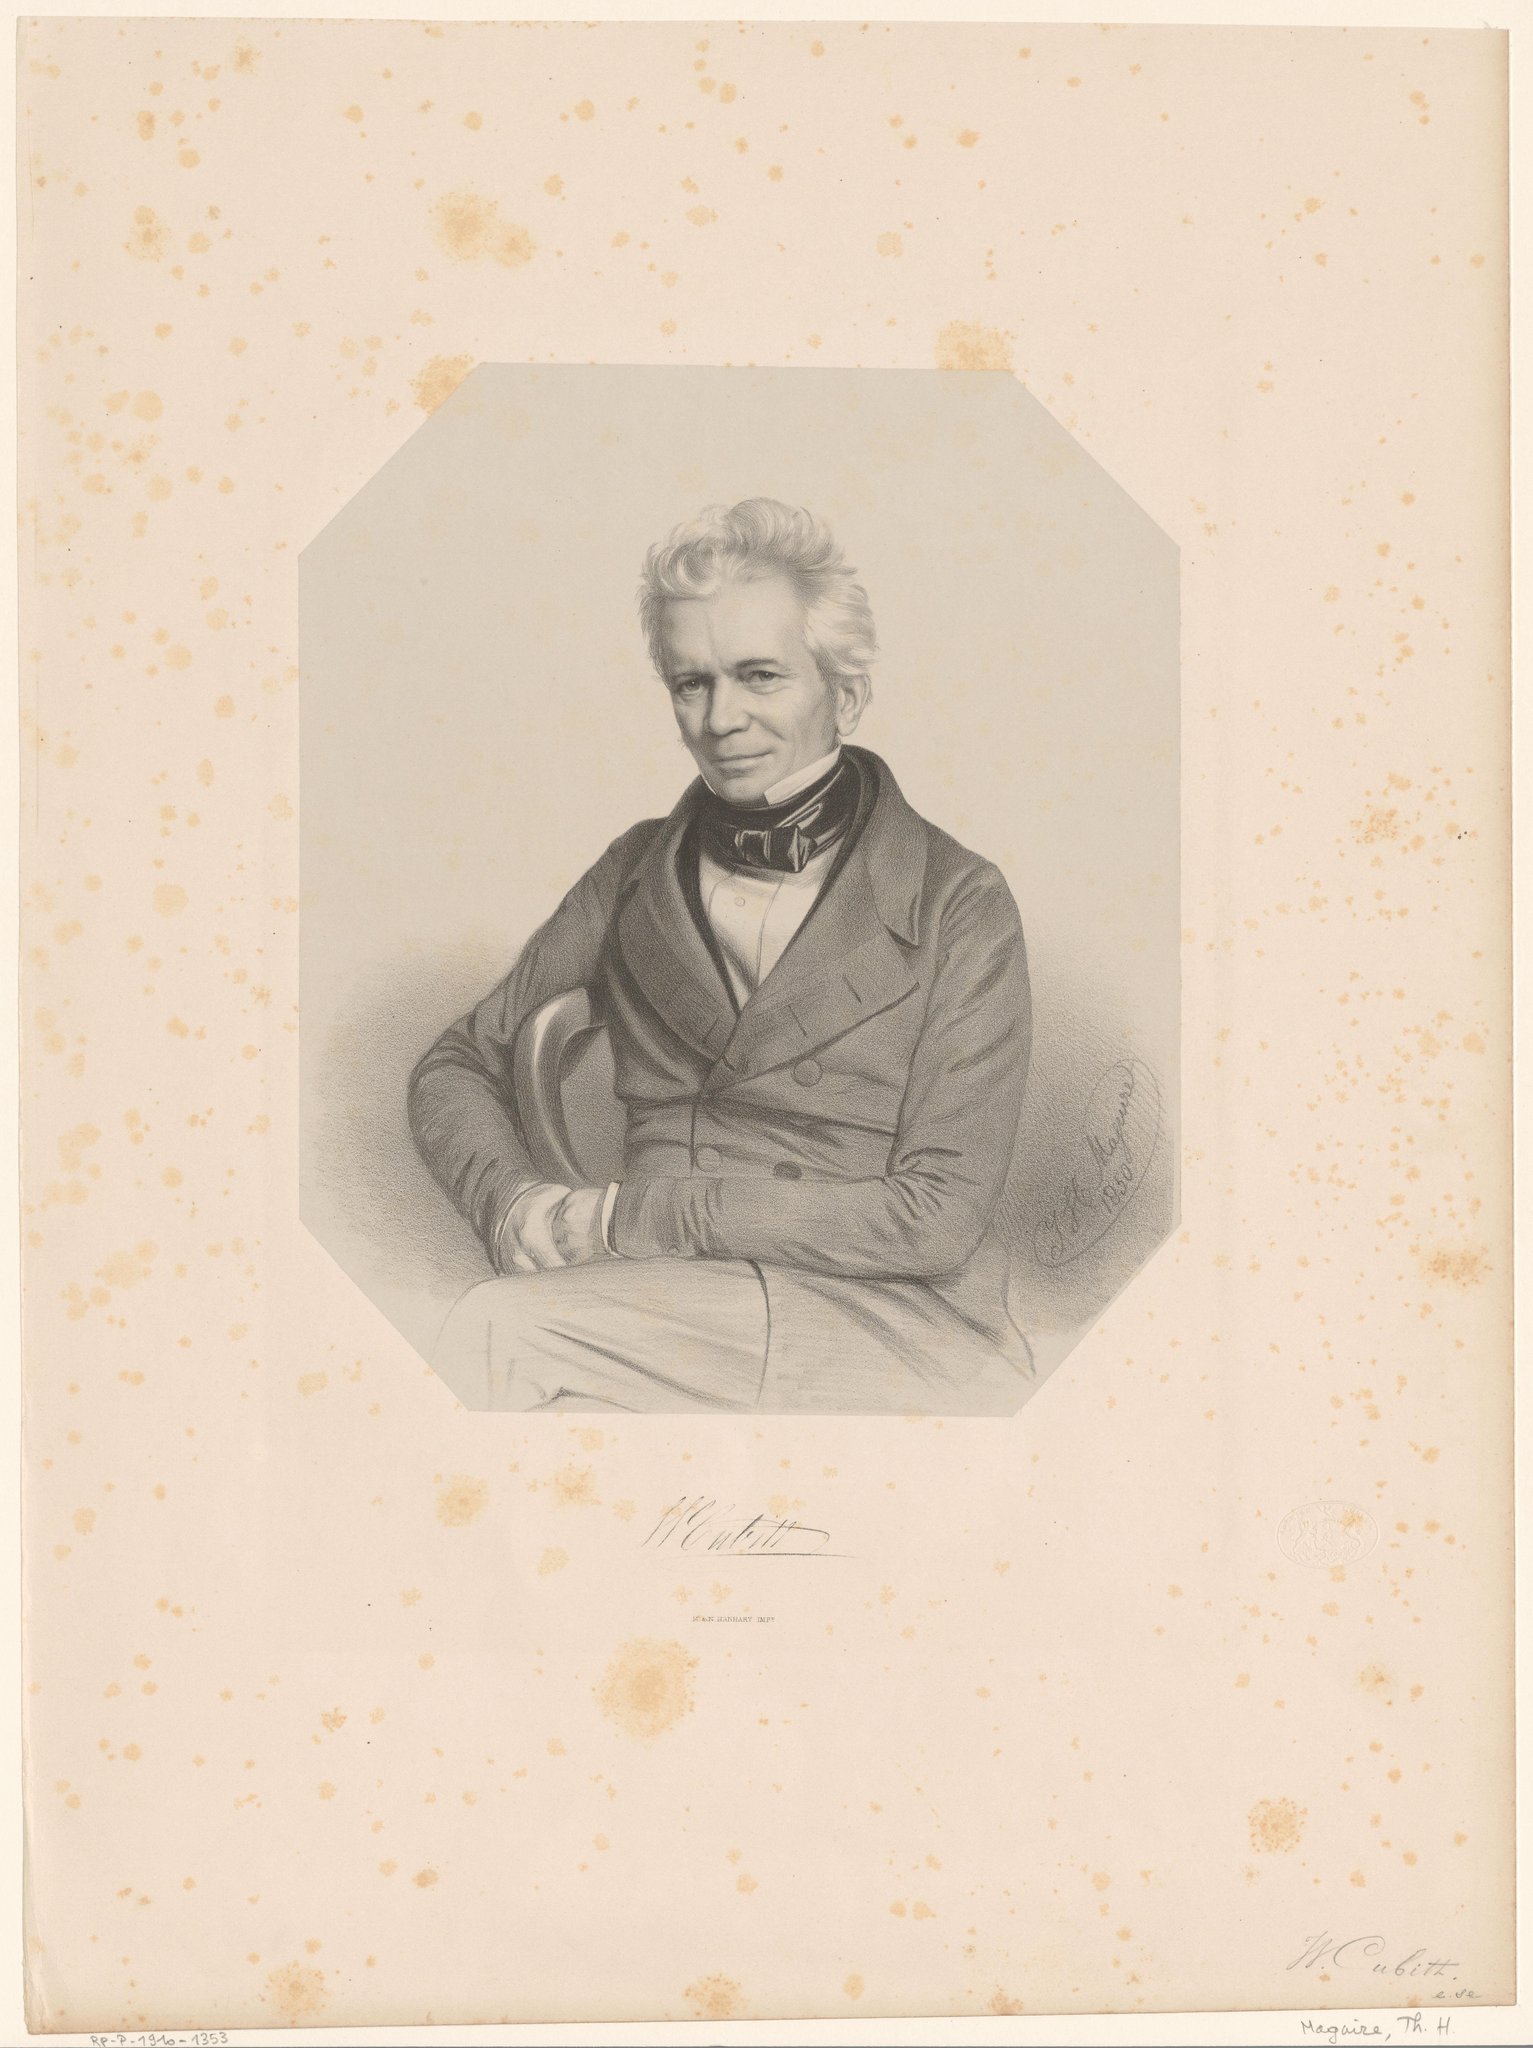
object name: print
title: Portretten uit het Ipswich Museum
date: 1852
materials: paper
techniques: lithograph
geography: london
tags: adult man, historical persons, chair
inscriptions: check stamp: ‘Ipswich Museum’, collector's mark: Lugt 2228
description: Prent behoort tot de serie 'Ipswich Museum Portraits', ook bekend onder de titel 'Portraits of Honorary Members of the Ipswich Museum'. Deze serie is in 1852 door George Ransome uitgegeven en gedrukt door M&N Hanhart tussen 1848 en 1852. De serie bestaat uit ca. 60 portretten.